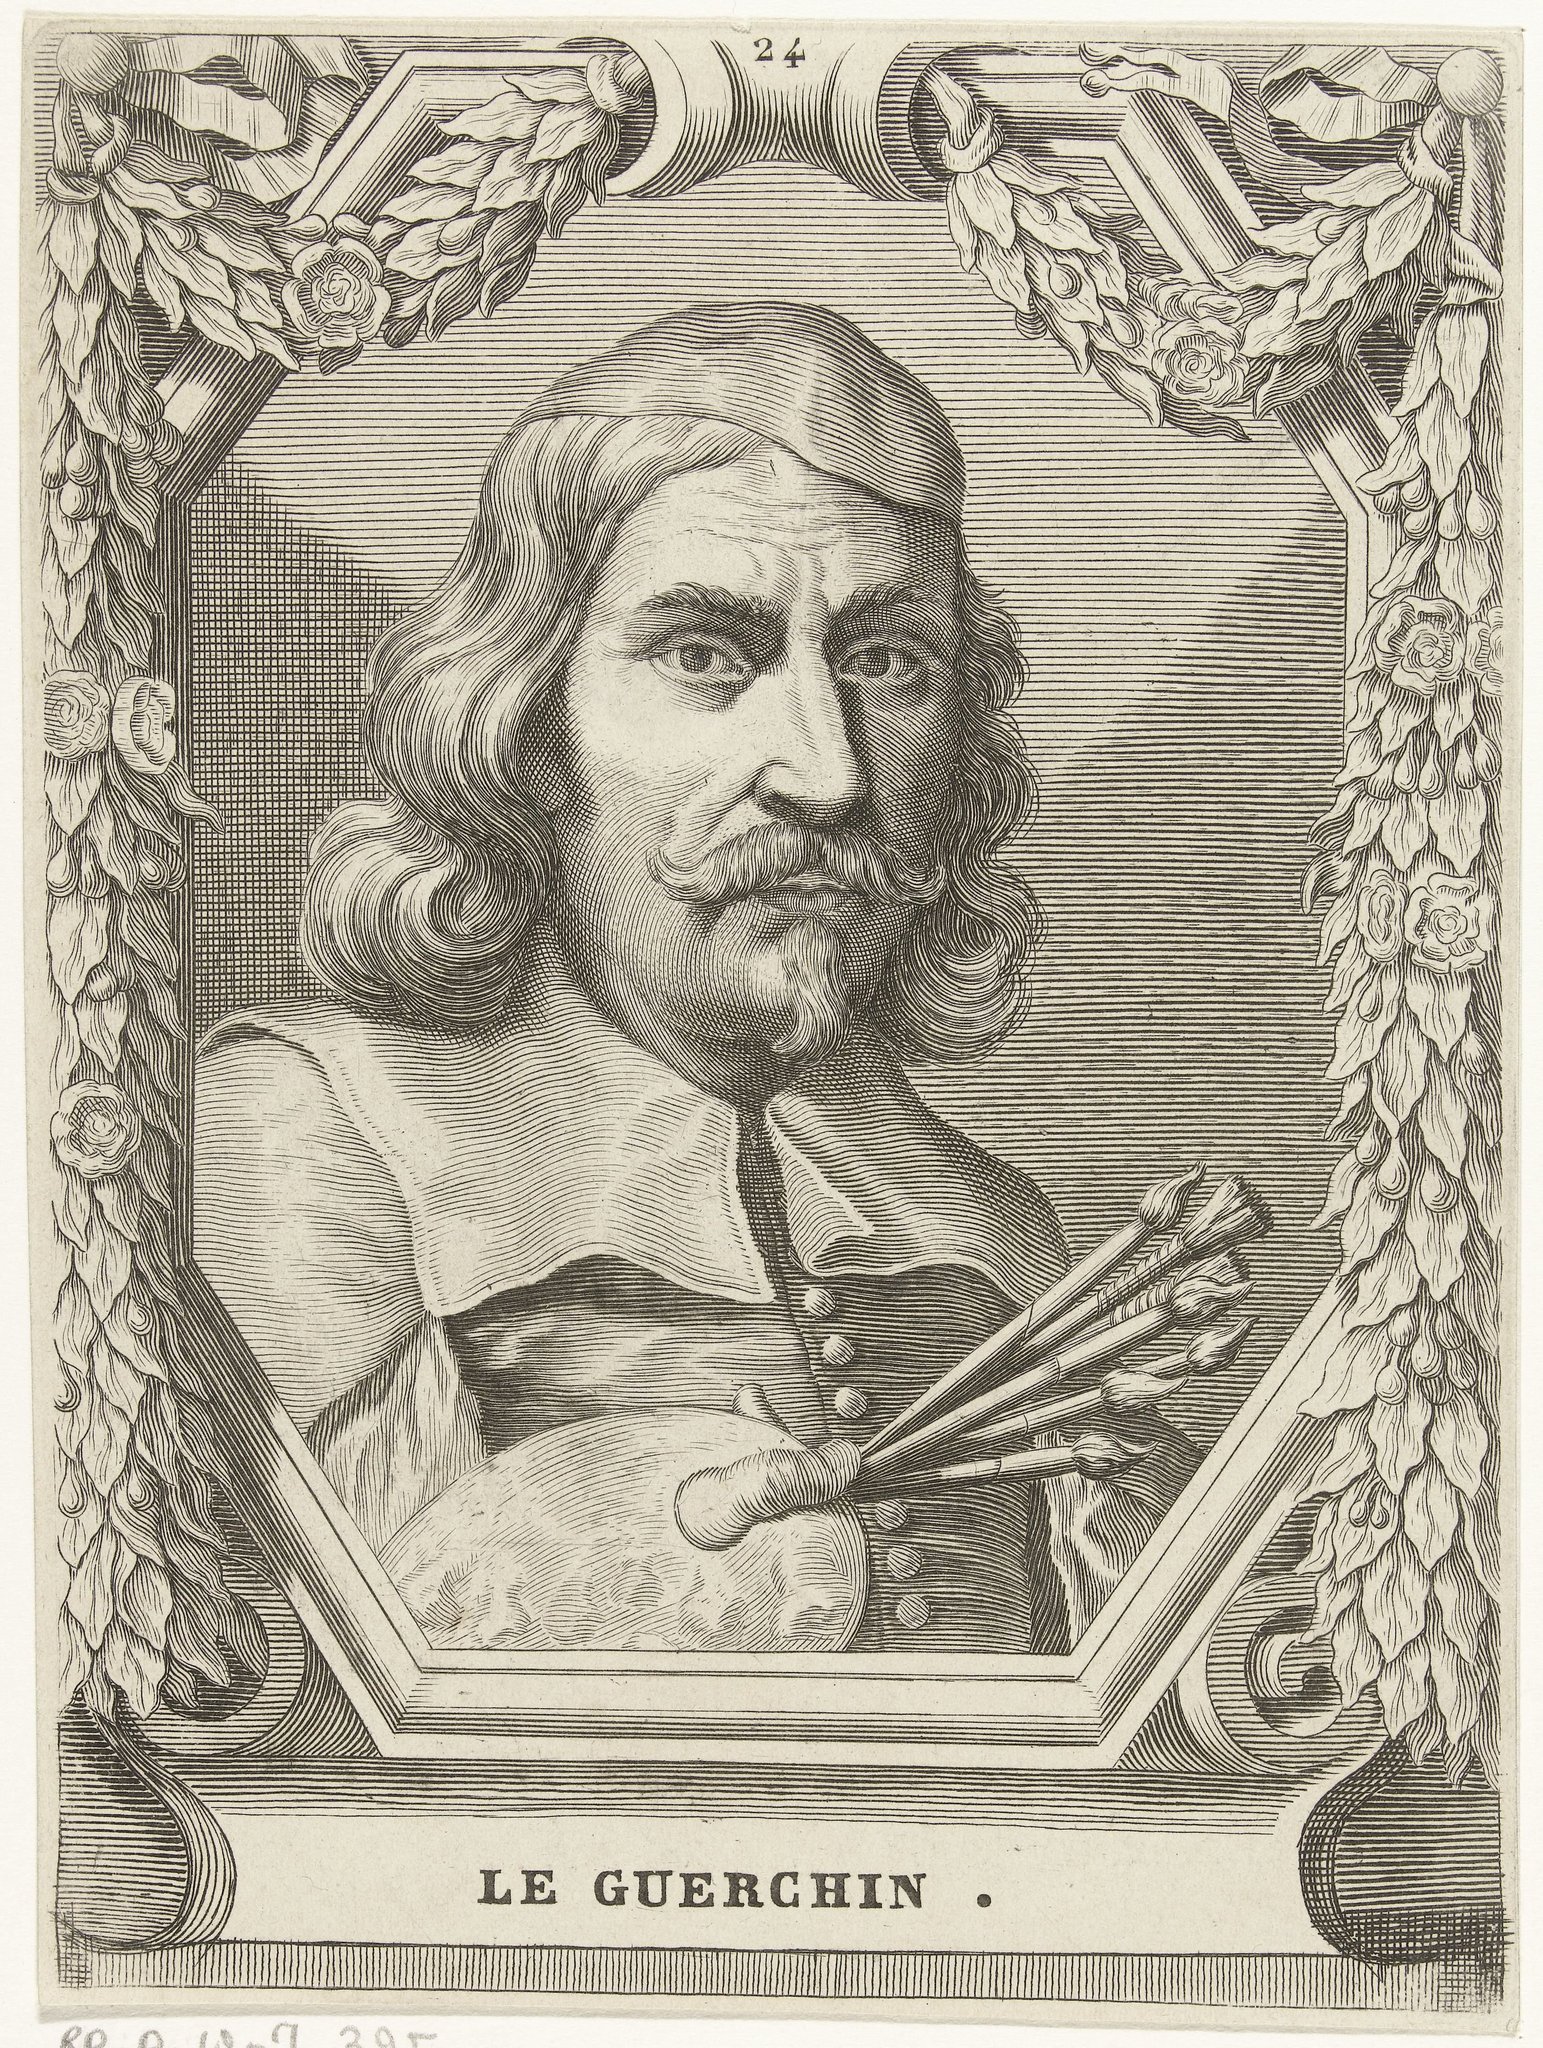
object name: print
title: Portret van Guercino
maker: albertus clouwet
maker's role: print maker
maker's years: 1636-1679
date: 1646-1679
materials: paper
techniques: engraving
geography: rome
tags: painter, draughtsman, guercino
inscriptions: collector's mark: Lugt 2228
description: Octagonaal portret van Giovanni Francesco Barbieri, beter bekend als Guercino, een Italiaanse schilder. Buste naar rechts.